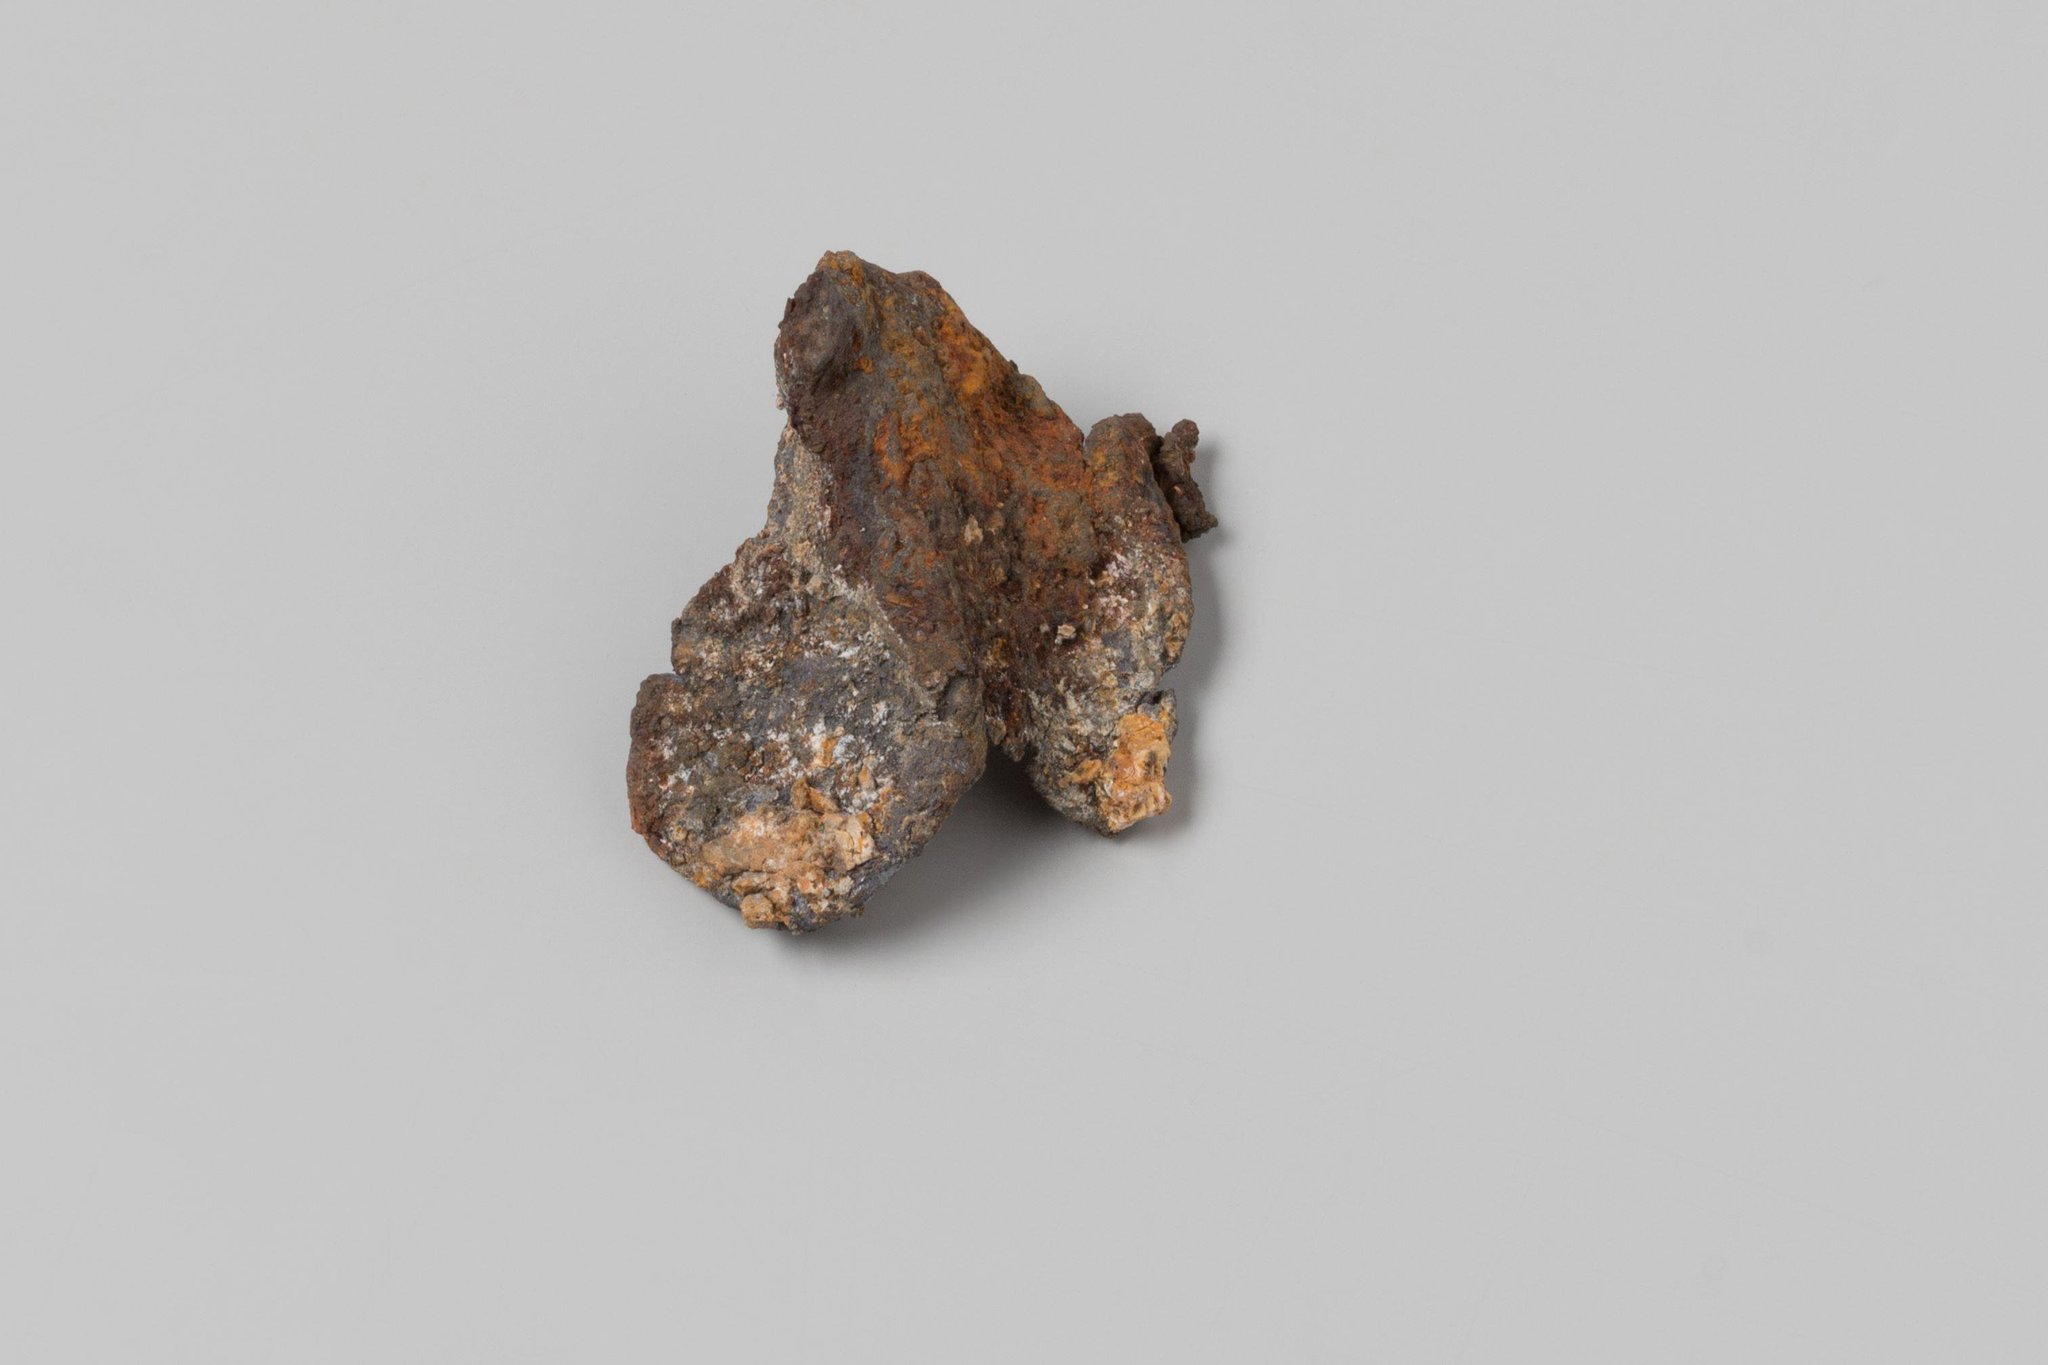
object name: fragment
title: Fragment tin uit het wrak van de Oost-Indiëvaarder Hollandia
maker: Anonymous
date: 1700-1743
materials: lead, tin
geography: netherlands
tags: verenigde oostindische compagnie, hollandia (schip), annet